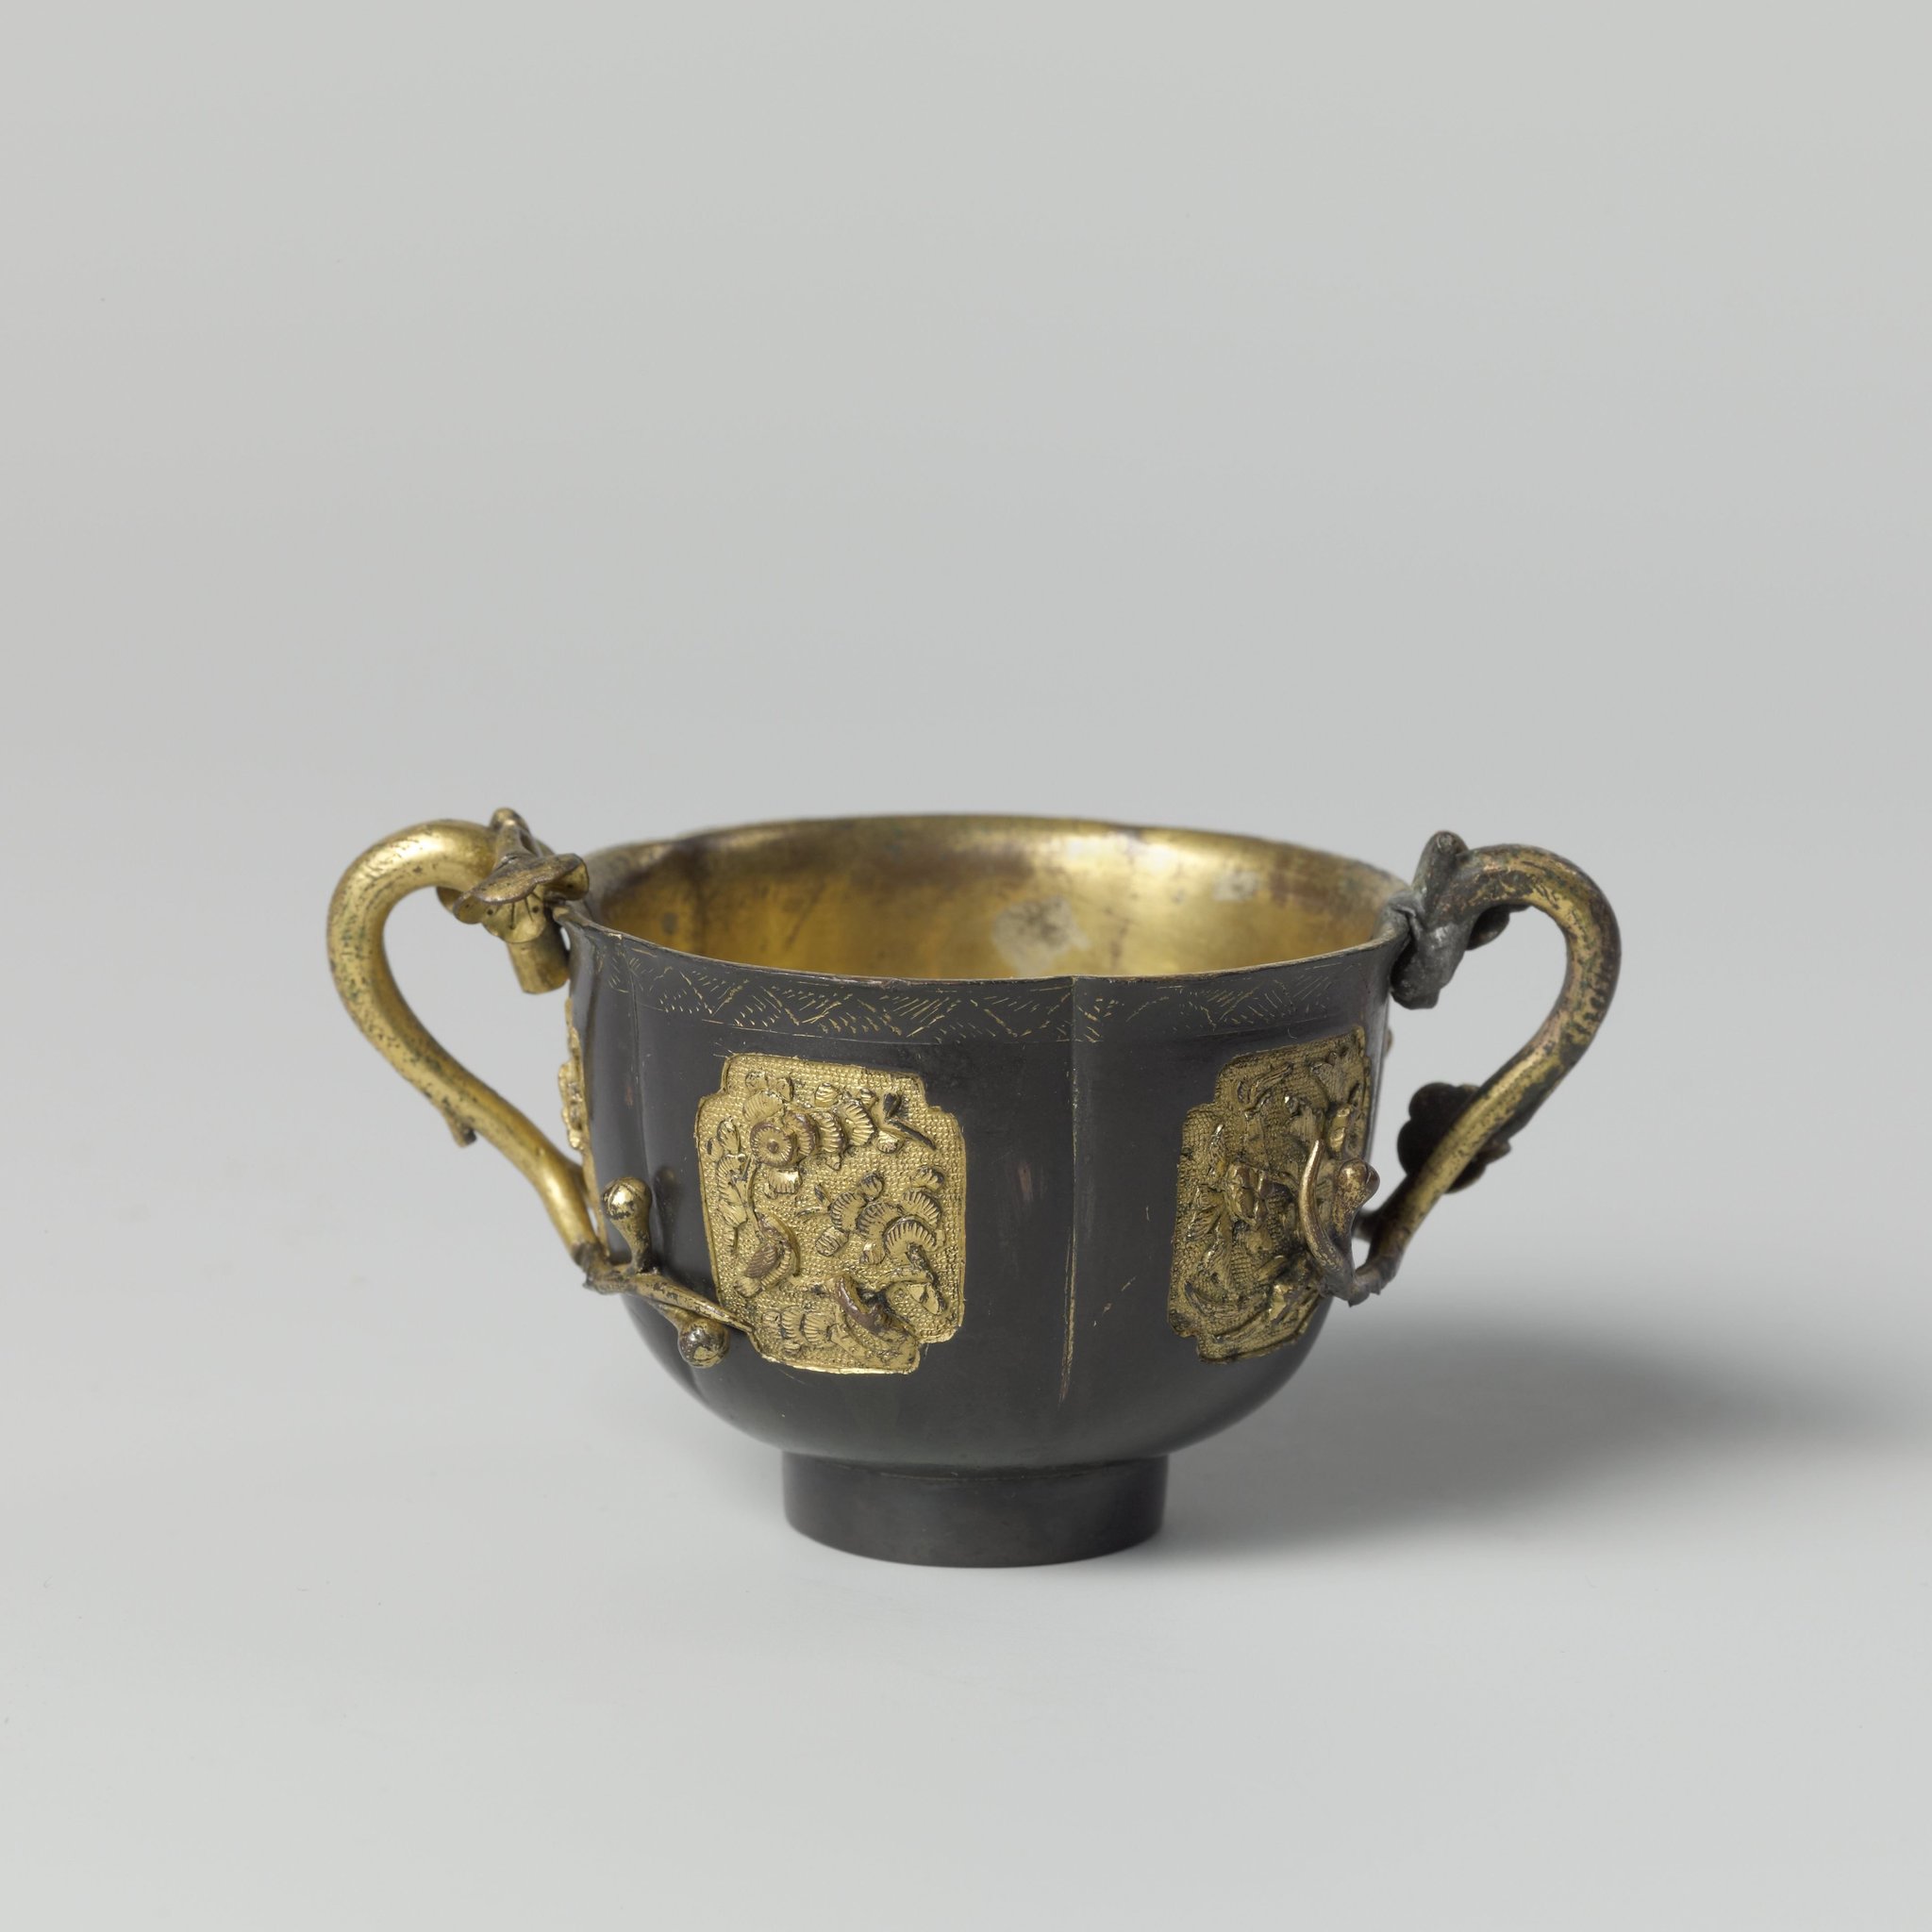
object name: cup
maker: Anonymous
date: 1700-1800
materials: metal alloy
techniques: amalgam gilded, casting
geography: tonkin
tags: verenigde oostindische compagnie, vietnam, kanton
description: Bekervormig kopje op voetring, buitenzijde zwart gemoffeld, binnenzijde (vuur-)vergulde suassa. bovenrand licht geschulpt met vijf verticale ribbels van rand tot voetring. Aan de buitenzijde vijf rechthoekige cartouches met uitgesneden versiering in verguld reliëf van takken met bladeren en bloemen, vogels en één cartouche met palmtakken en vruchten. Aan de buitenzijde langs de bovenrand een horizontale band met ingekerfde versiering. Aan weerszijden zijn vleugelvormige oren vastgeklonken, aan de onderzijde naar twee kanten uitlopend. Oren zijn gestileerde takken, deels glad en rond, die zich in tweeën splitsen, met (bloem-)knoppen en aan bovenzijde bloemen.